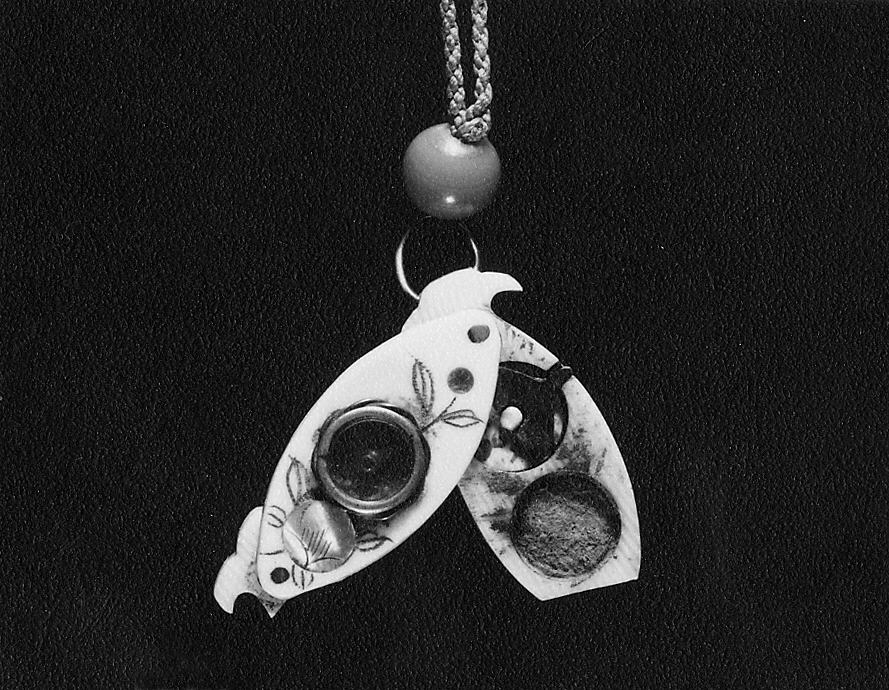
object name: seal with ink, in case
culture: chinese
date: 1867-1933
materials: brass, ink, ivory, mother of pearl